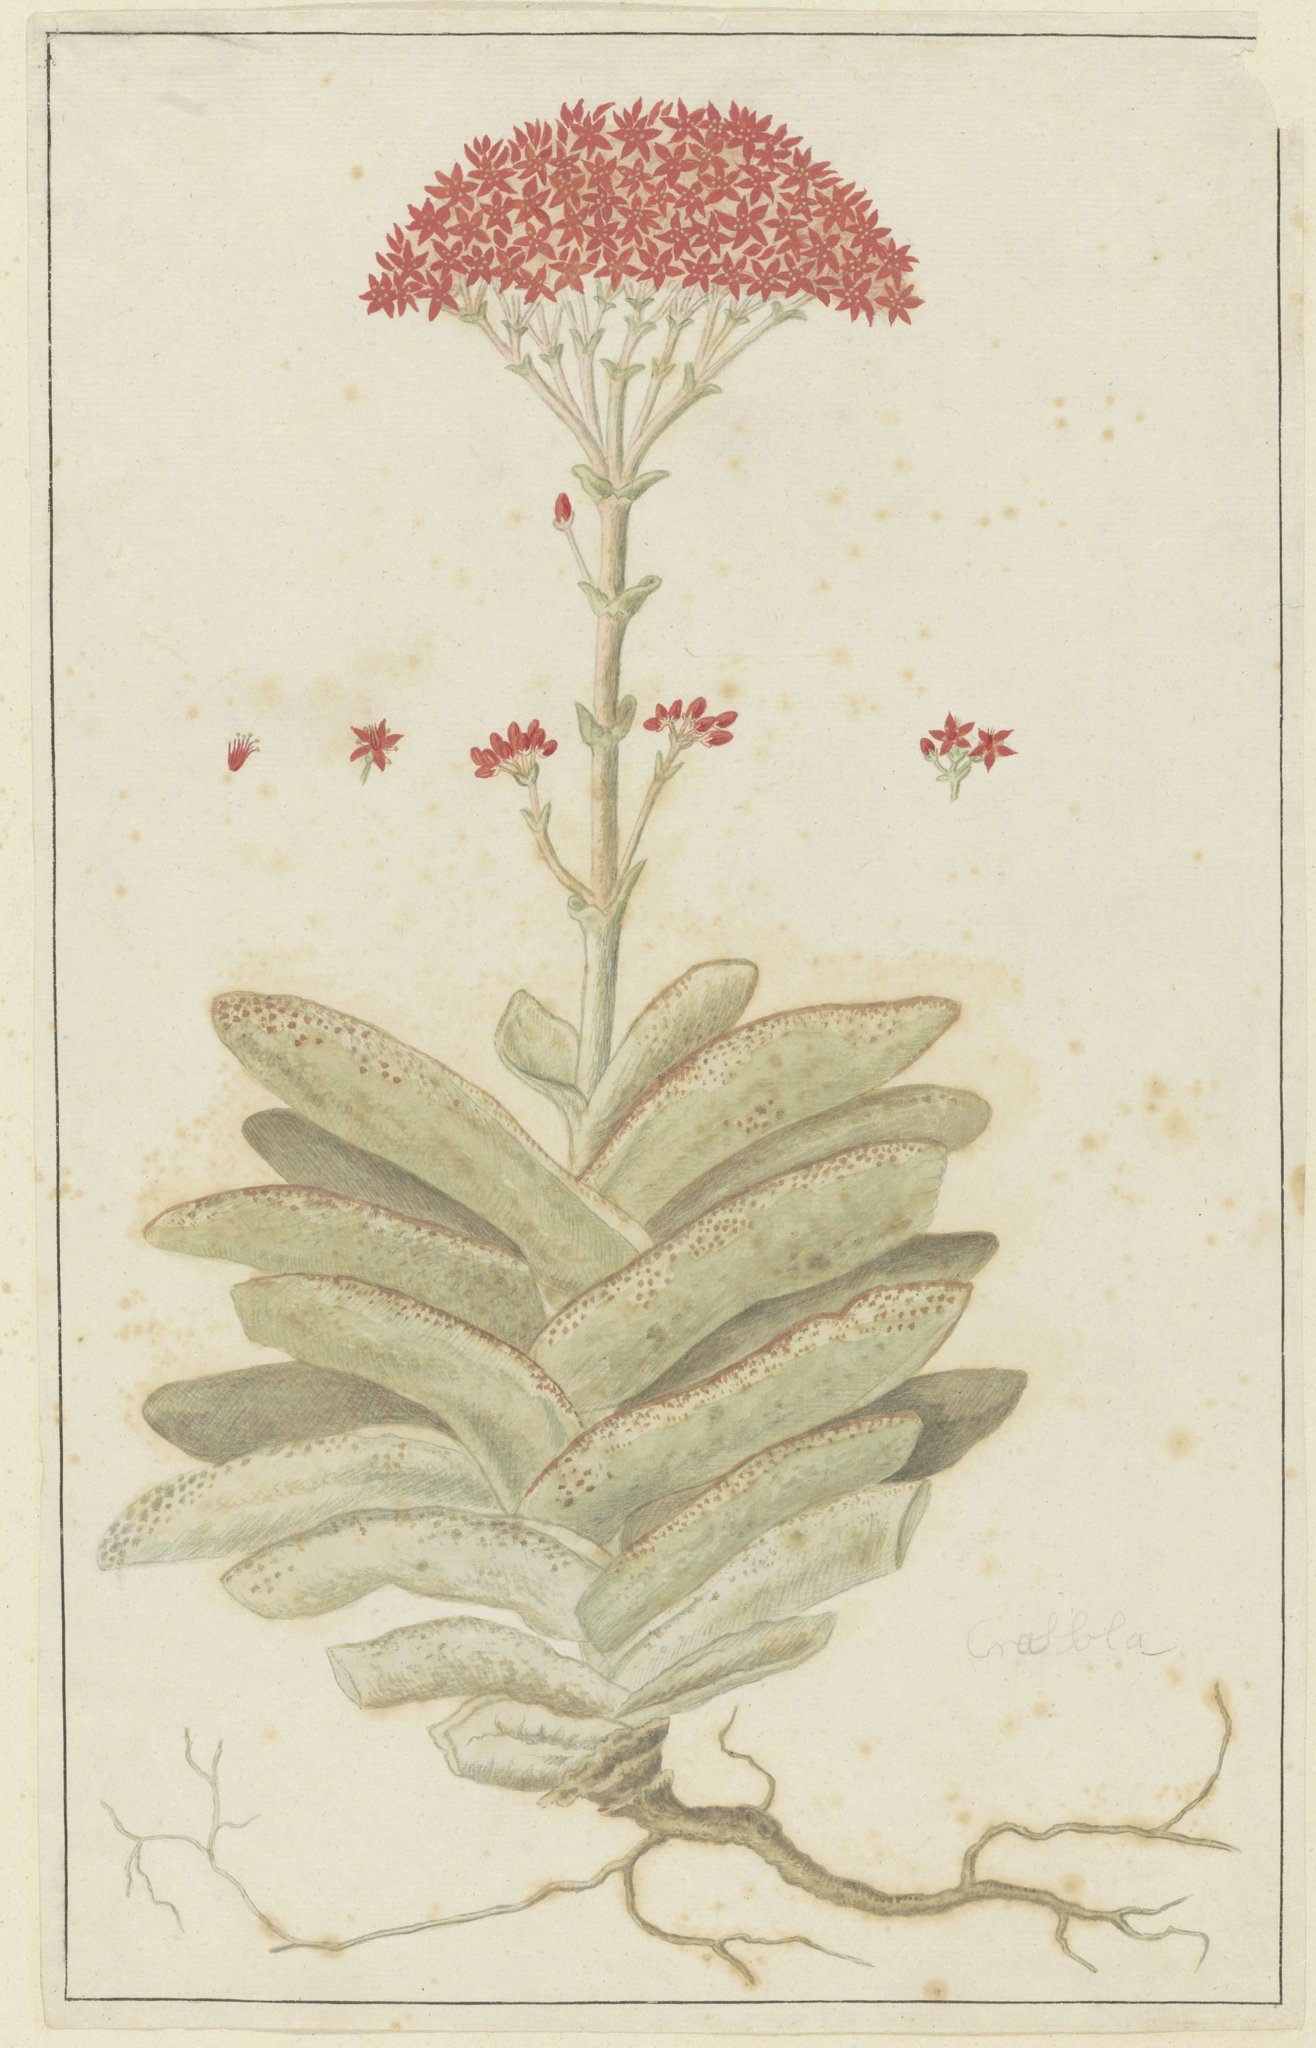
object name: album leaf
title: Crassula perfoliata L. (Sekelblaarplakkie)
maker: robert jacob gordon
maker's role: draughtsman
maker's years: 1743-1795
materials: chalk, ink, paper, pencil, watercolor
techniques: brush, pen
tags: plants; vegetation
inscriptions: annotation: ‘Crassola’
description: De tekening is gemaakt voor of tijdens een van Gordon's vier expedities door de Kaapprovincie, van oktober 1777 tot maart 1786. Sommige (soort)namen kunnen zijn gewijzigd, gezien reorganisatie in plantentaxonomie gedurende de afgelopen jaren.